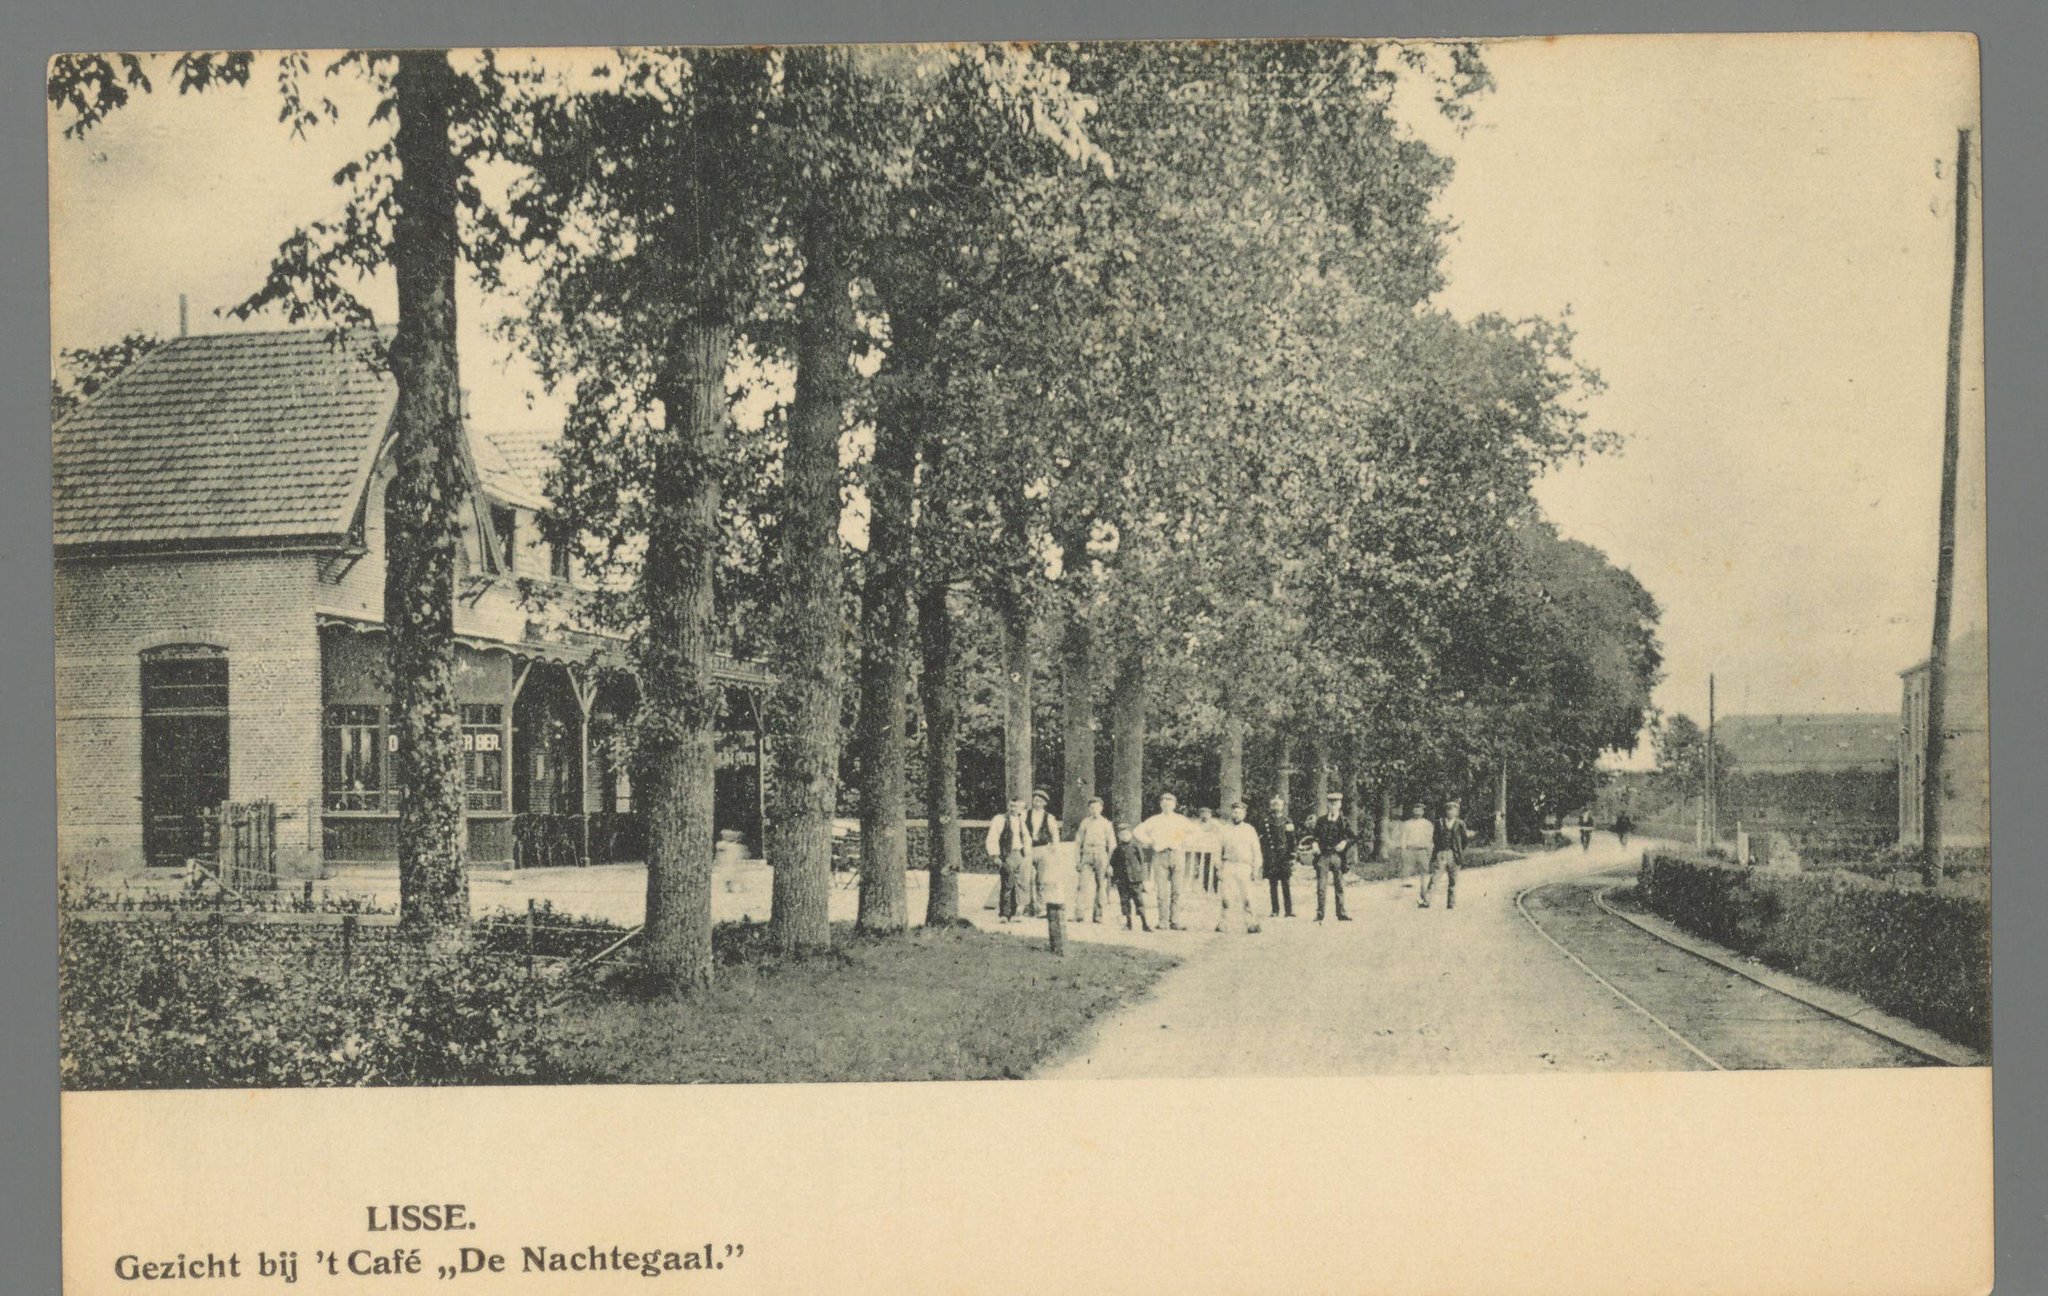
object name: photomechanical print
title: Lisse. Gezicht bij 't Café "De Nachtegaal"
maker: Anonymous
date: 1897-1905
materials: cardboard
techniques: photograph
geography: lisse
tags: inn, coffee-house, public house, etc., restaurant, street